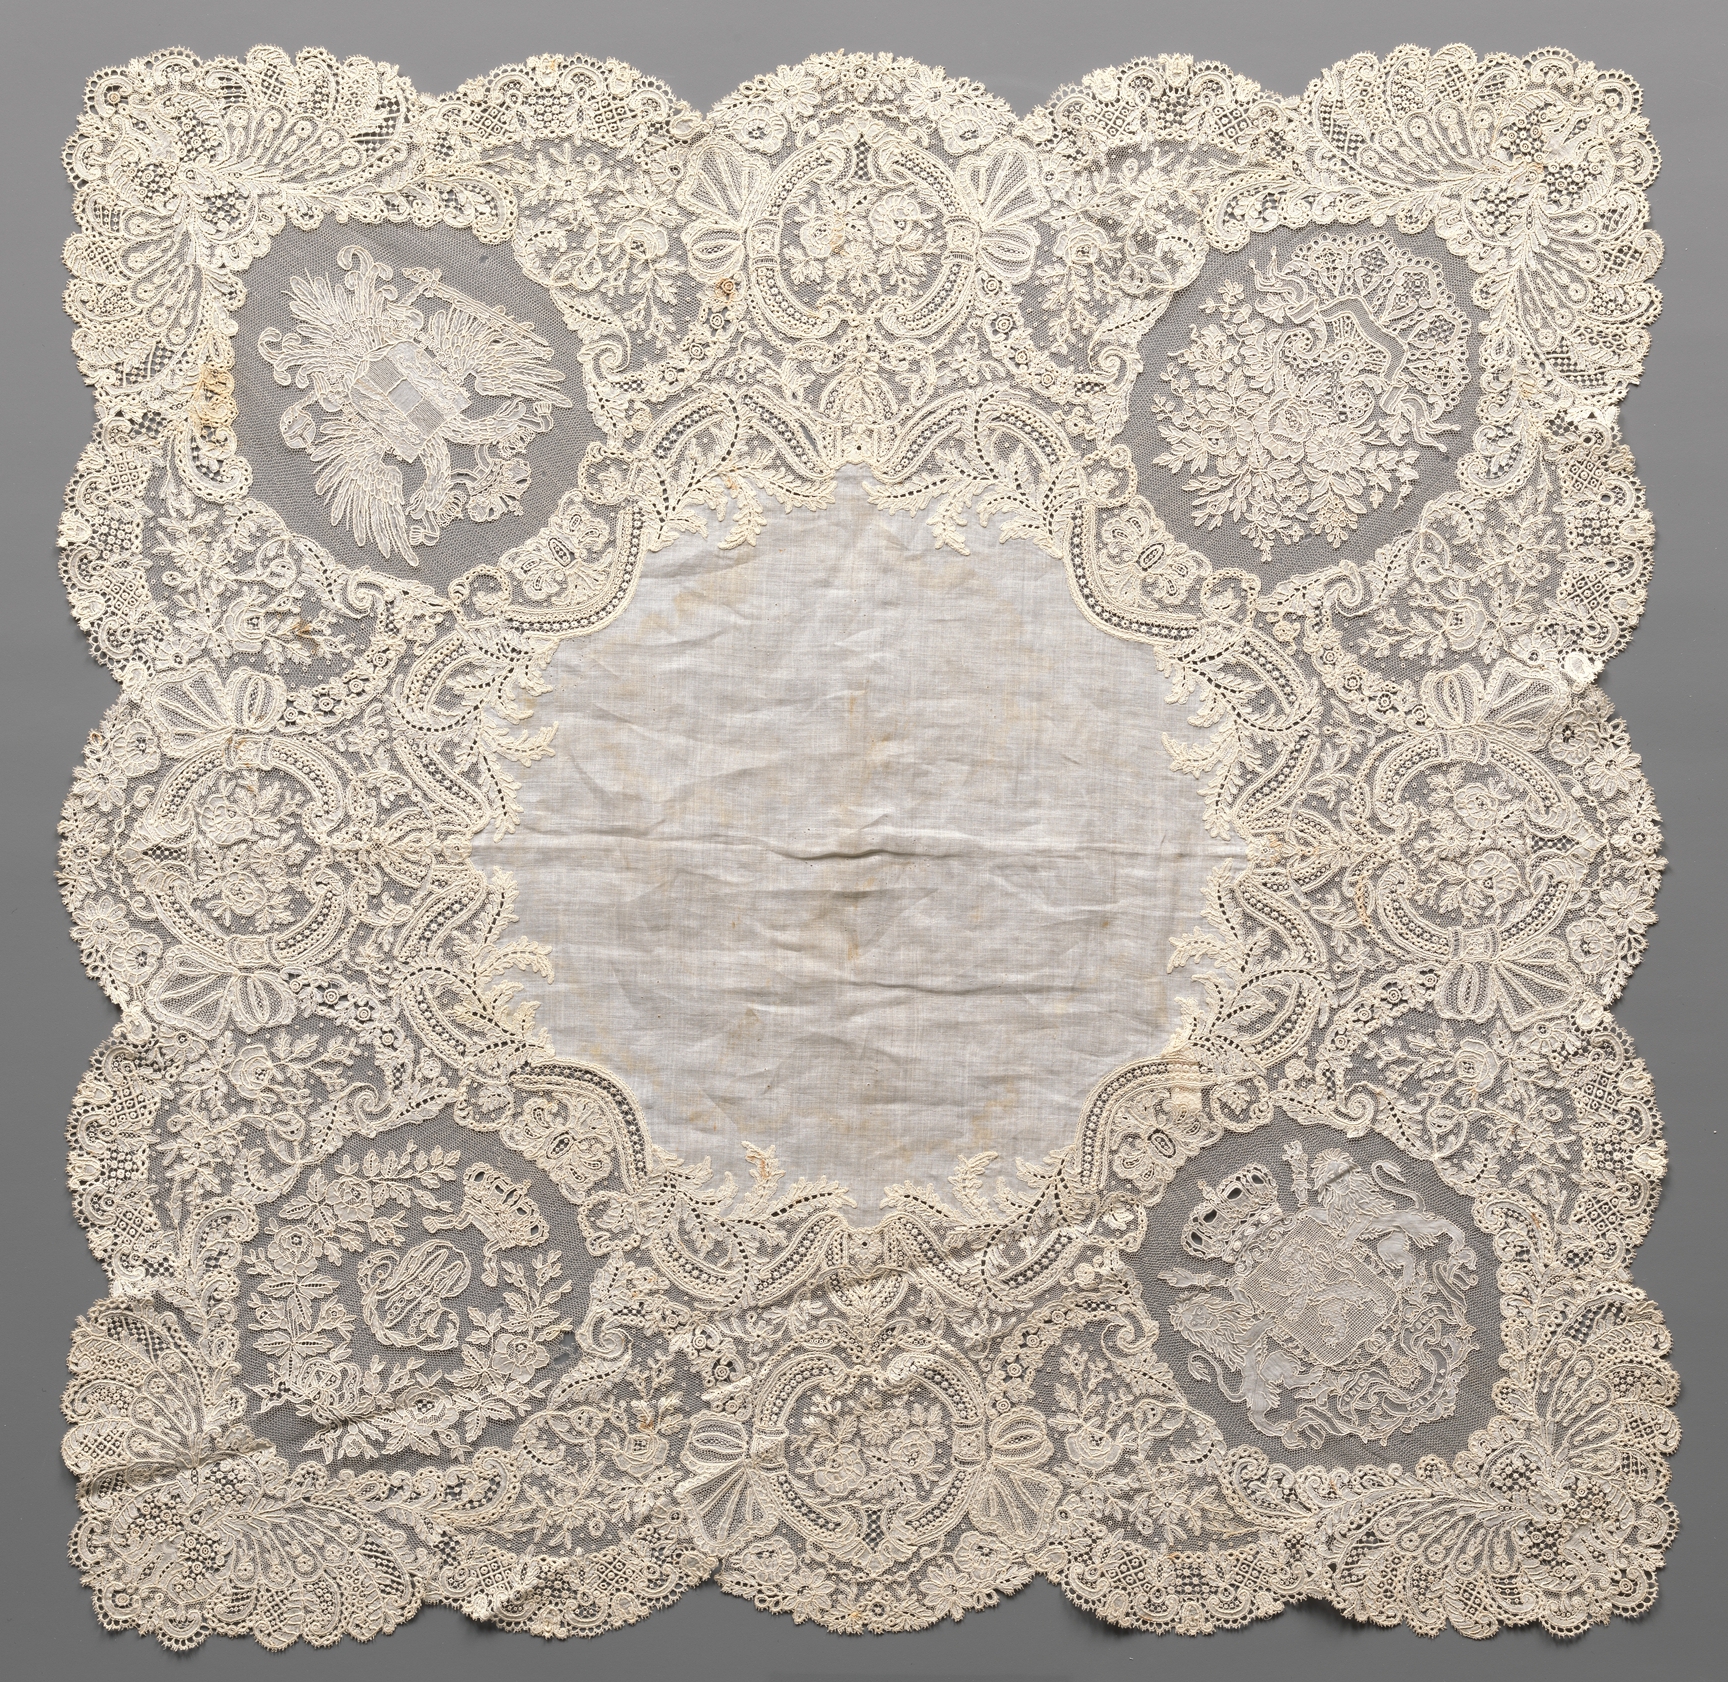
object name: handkerchief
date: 1853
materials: cotton, linen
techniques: lace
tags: flowers,coat of arms